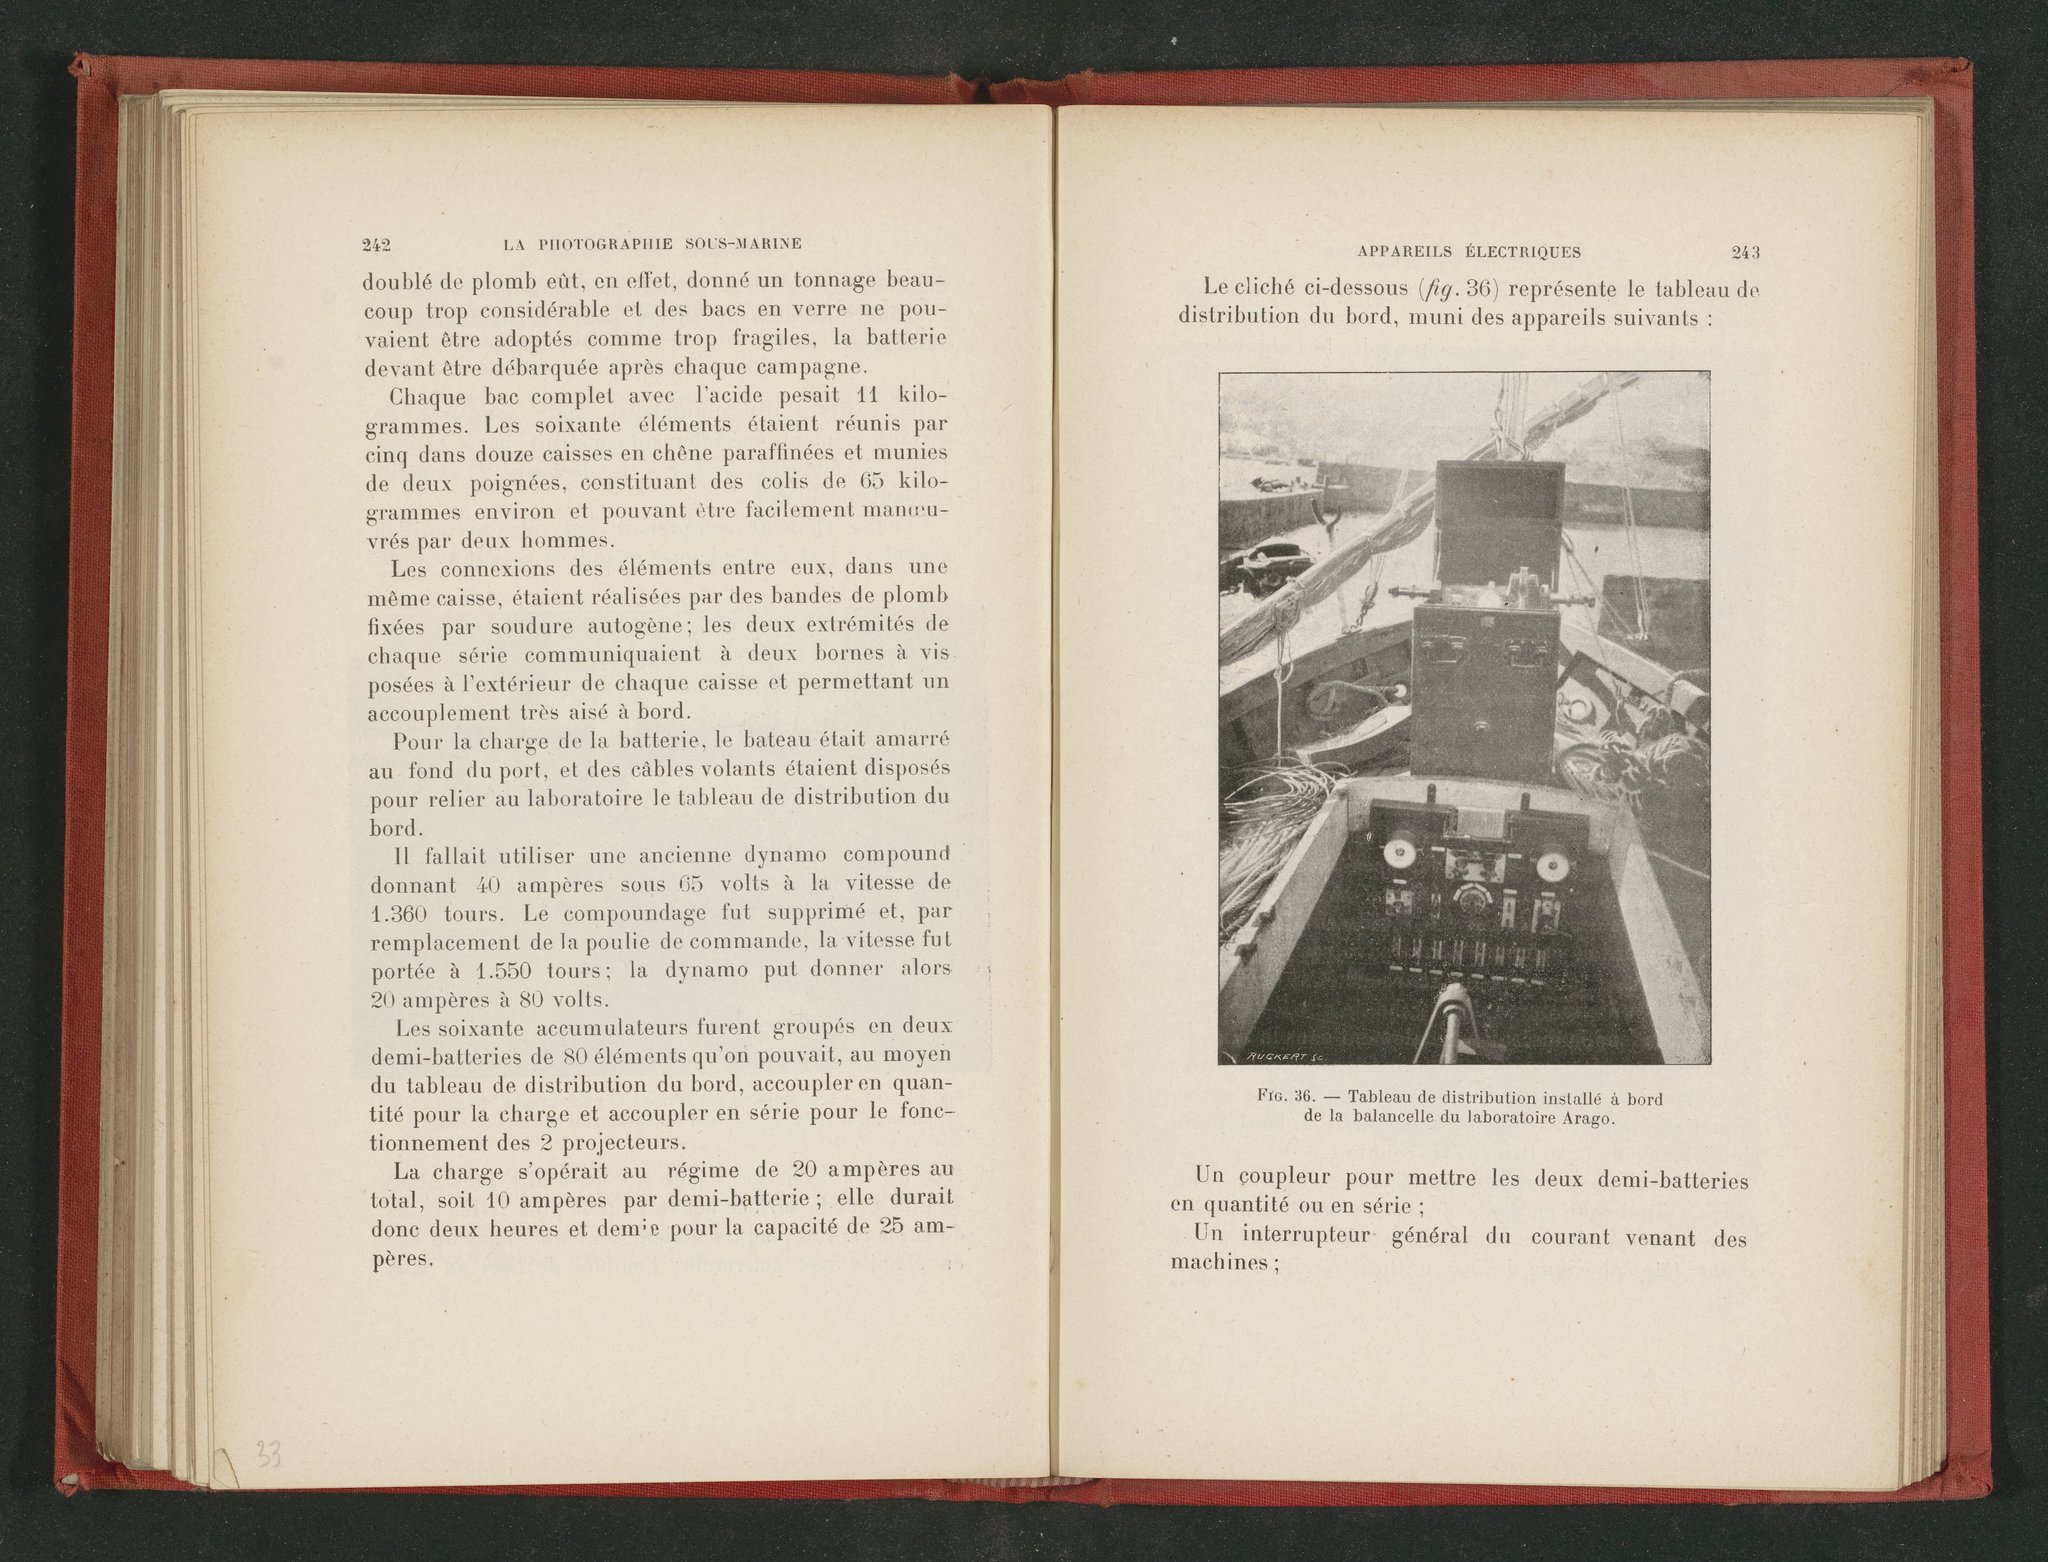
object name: photomechanical print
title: Tableau de distribution installé à bord de la balancelle du laboratoire Arago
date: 1890-1900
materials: paper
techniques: autotype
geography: laboratoire arago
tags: post, telegraph and telephone; means of communication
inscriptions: number: ‘Fig. 36.’